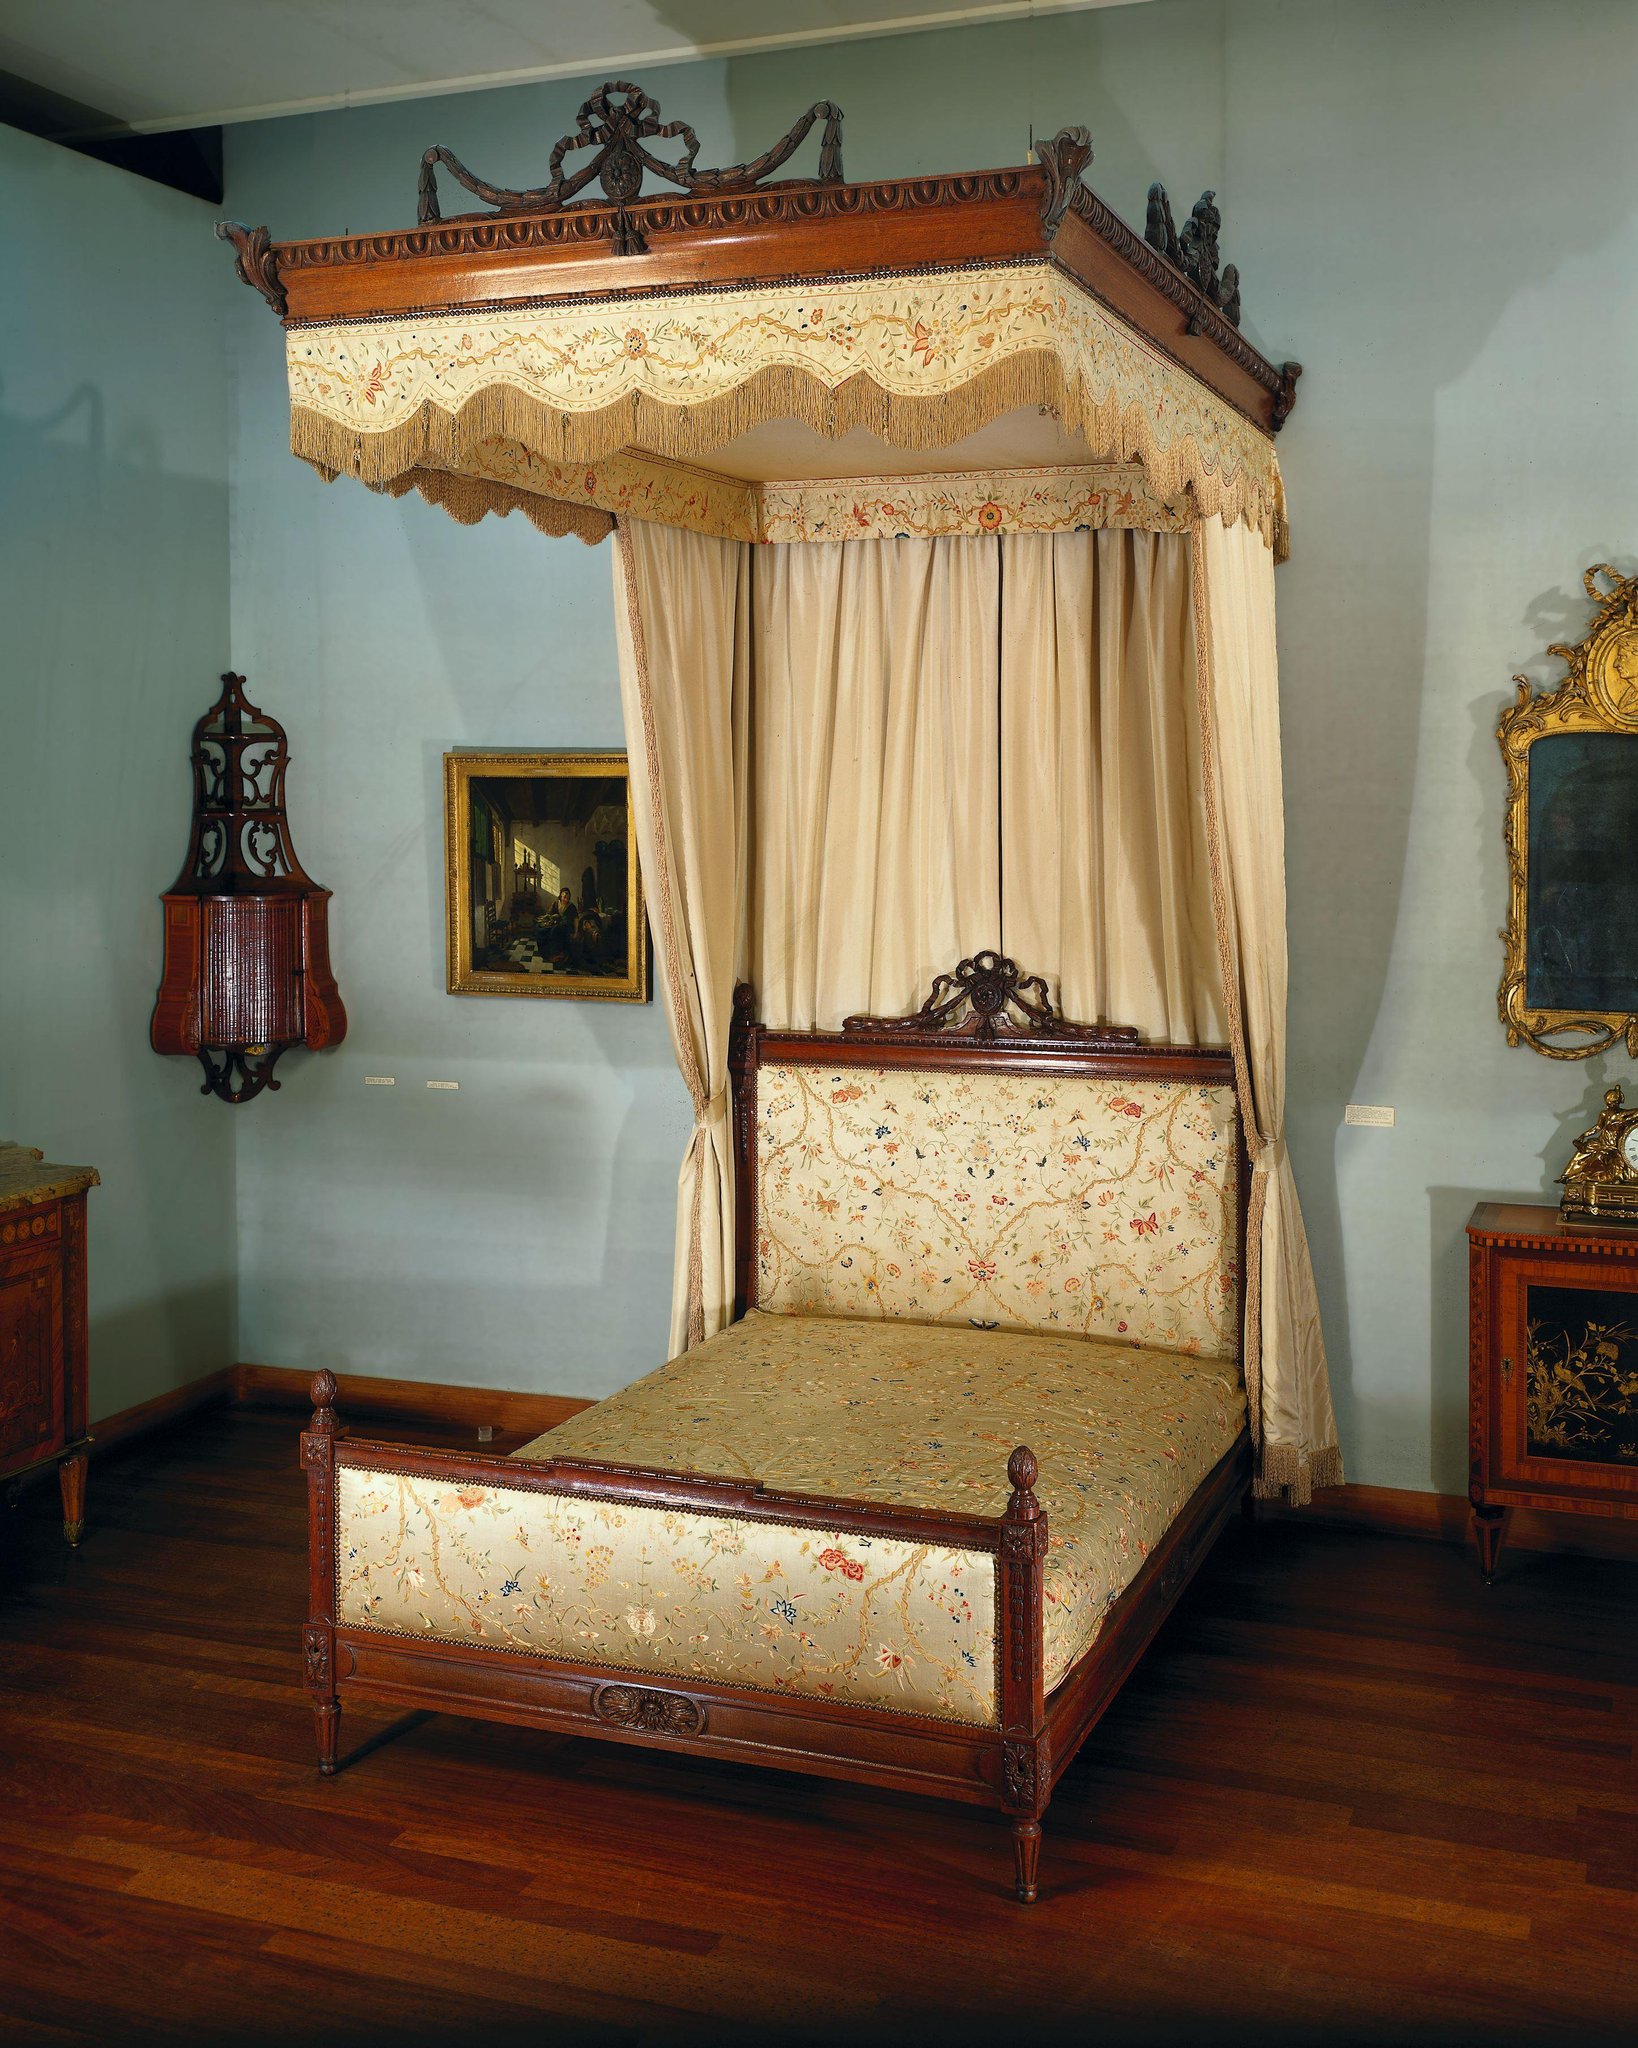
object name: textile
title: Sprei van kleurig geborduurde crème-witte satijn, met bloemranken en insekten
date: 1750-1800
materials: silk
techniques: embroidered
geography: china